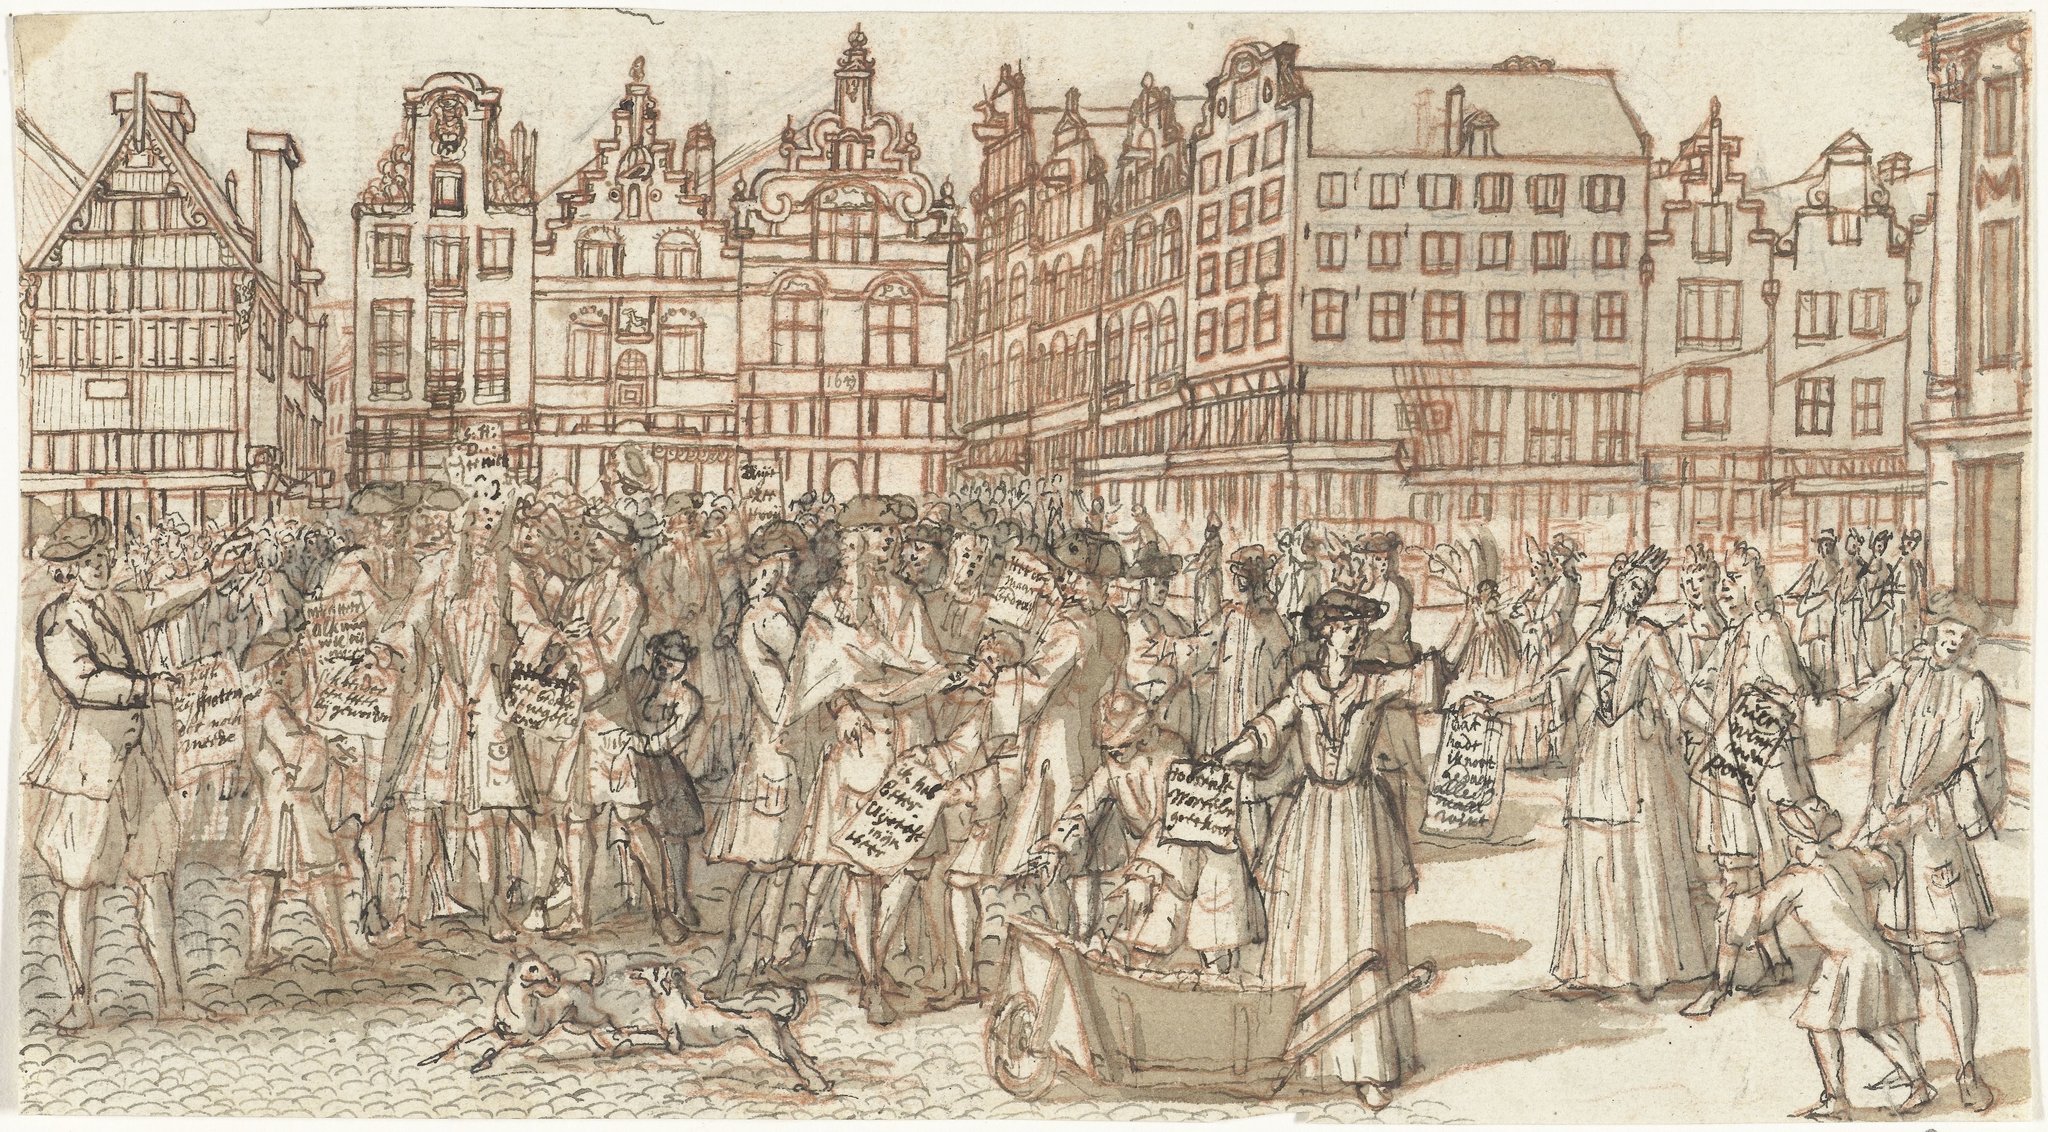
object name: drawing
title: Het Groote Tafereel der Dwaasheid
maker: Anonymous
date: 1720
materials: paper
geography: northern netherlands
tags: financial panic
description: Uitgeknipt blad met het getekende ontwerp voor de voorstelling van de menigte slachtoffers van de windhandel verzameld op de Dam bij de Kalverstraatschuldeiser, onderdeel van de prent met de Op- en Ondergang van de Actionisten. Ontwerp voor een onderdeel van prent 7 in de serie Het Groote Tafereel der Dwaasheid met spotprenten op de Windhandel of Actiehandel van 1720. Ontwerp voor een prent.